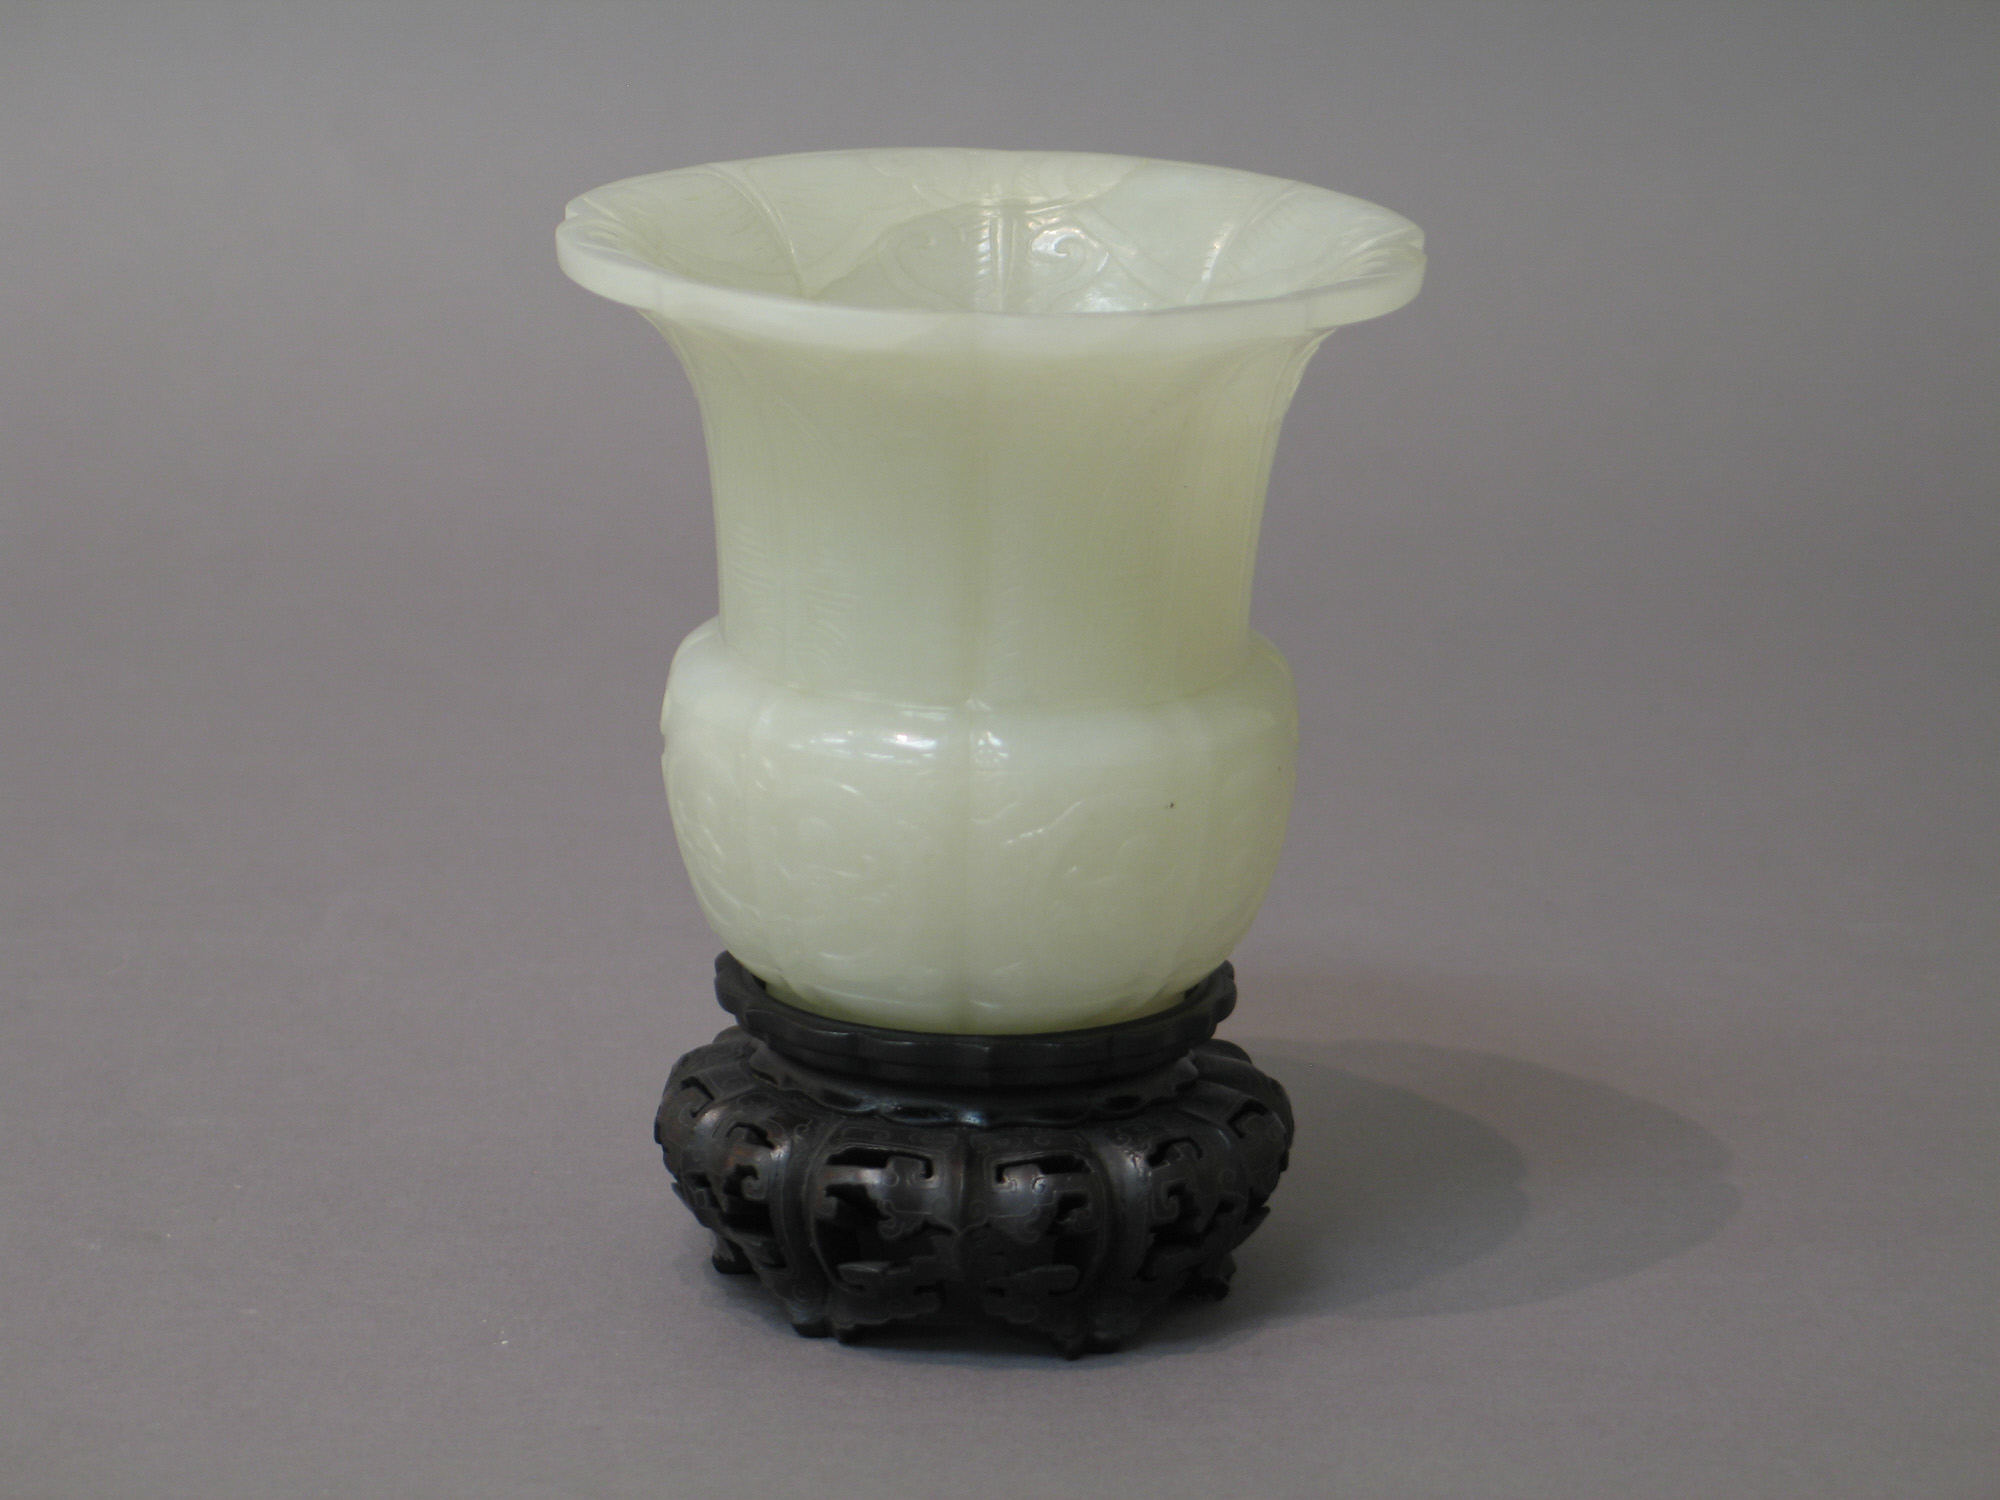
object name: vase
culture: chinese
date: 1736-1795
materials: jade